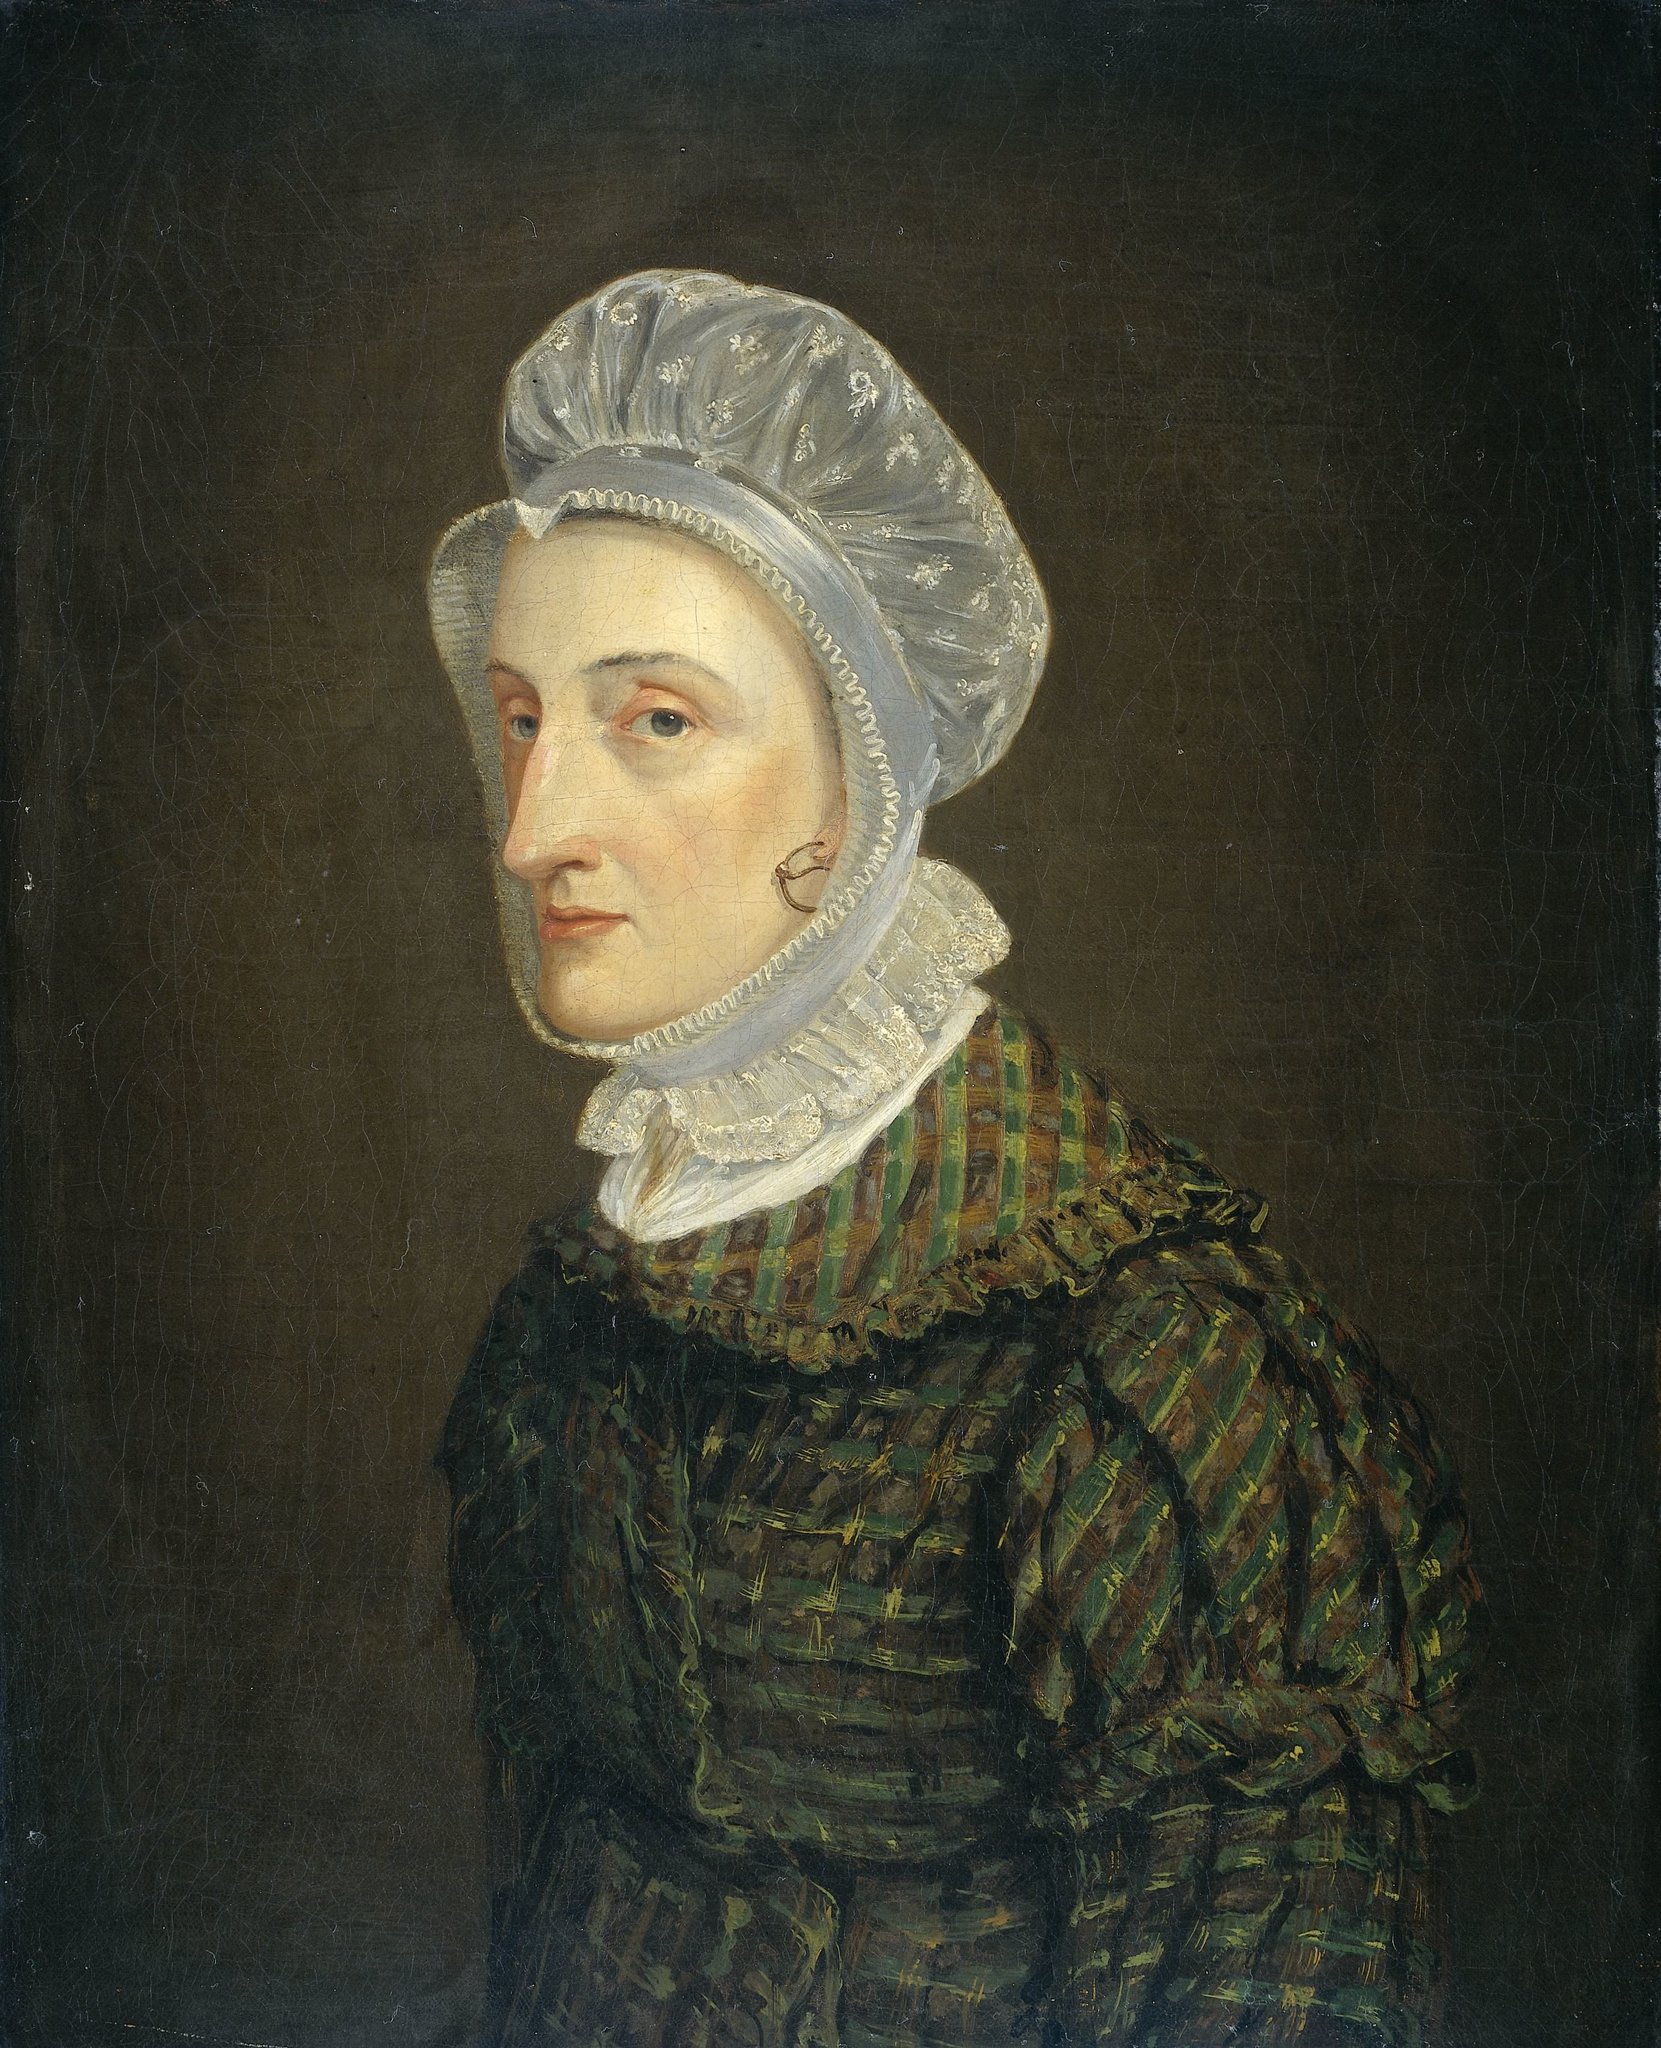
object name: painting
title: Portrait of Maria Petronella Mann, Wife of Heinrich Gottfried Theodor Crone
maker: jan philip simon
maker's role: painter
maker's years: 1796-1838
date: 1810-1838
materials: canvas, oil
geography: netherlands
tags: amsterdam, historical persons - bb - woman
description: Portret van Maria Petronella Mann (1778-1825), de echtgenote van Heinrich Gottfried Theodor Crone. Buste, naar links, met een witte kanten muts. Pendant van SK-A-4913.